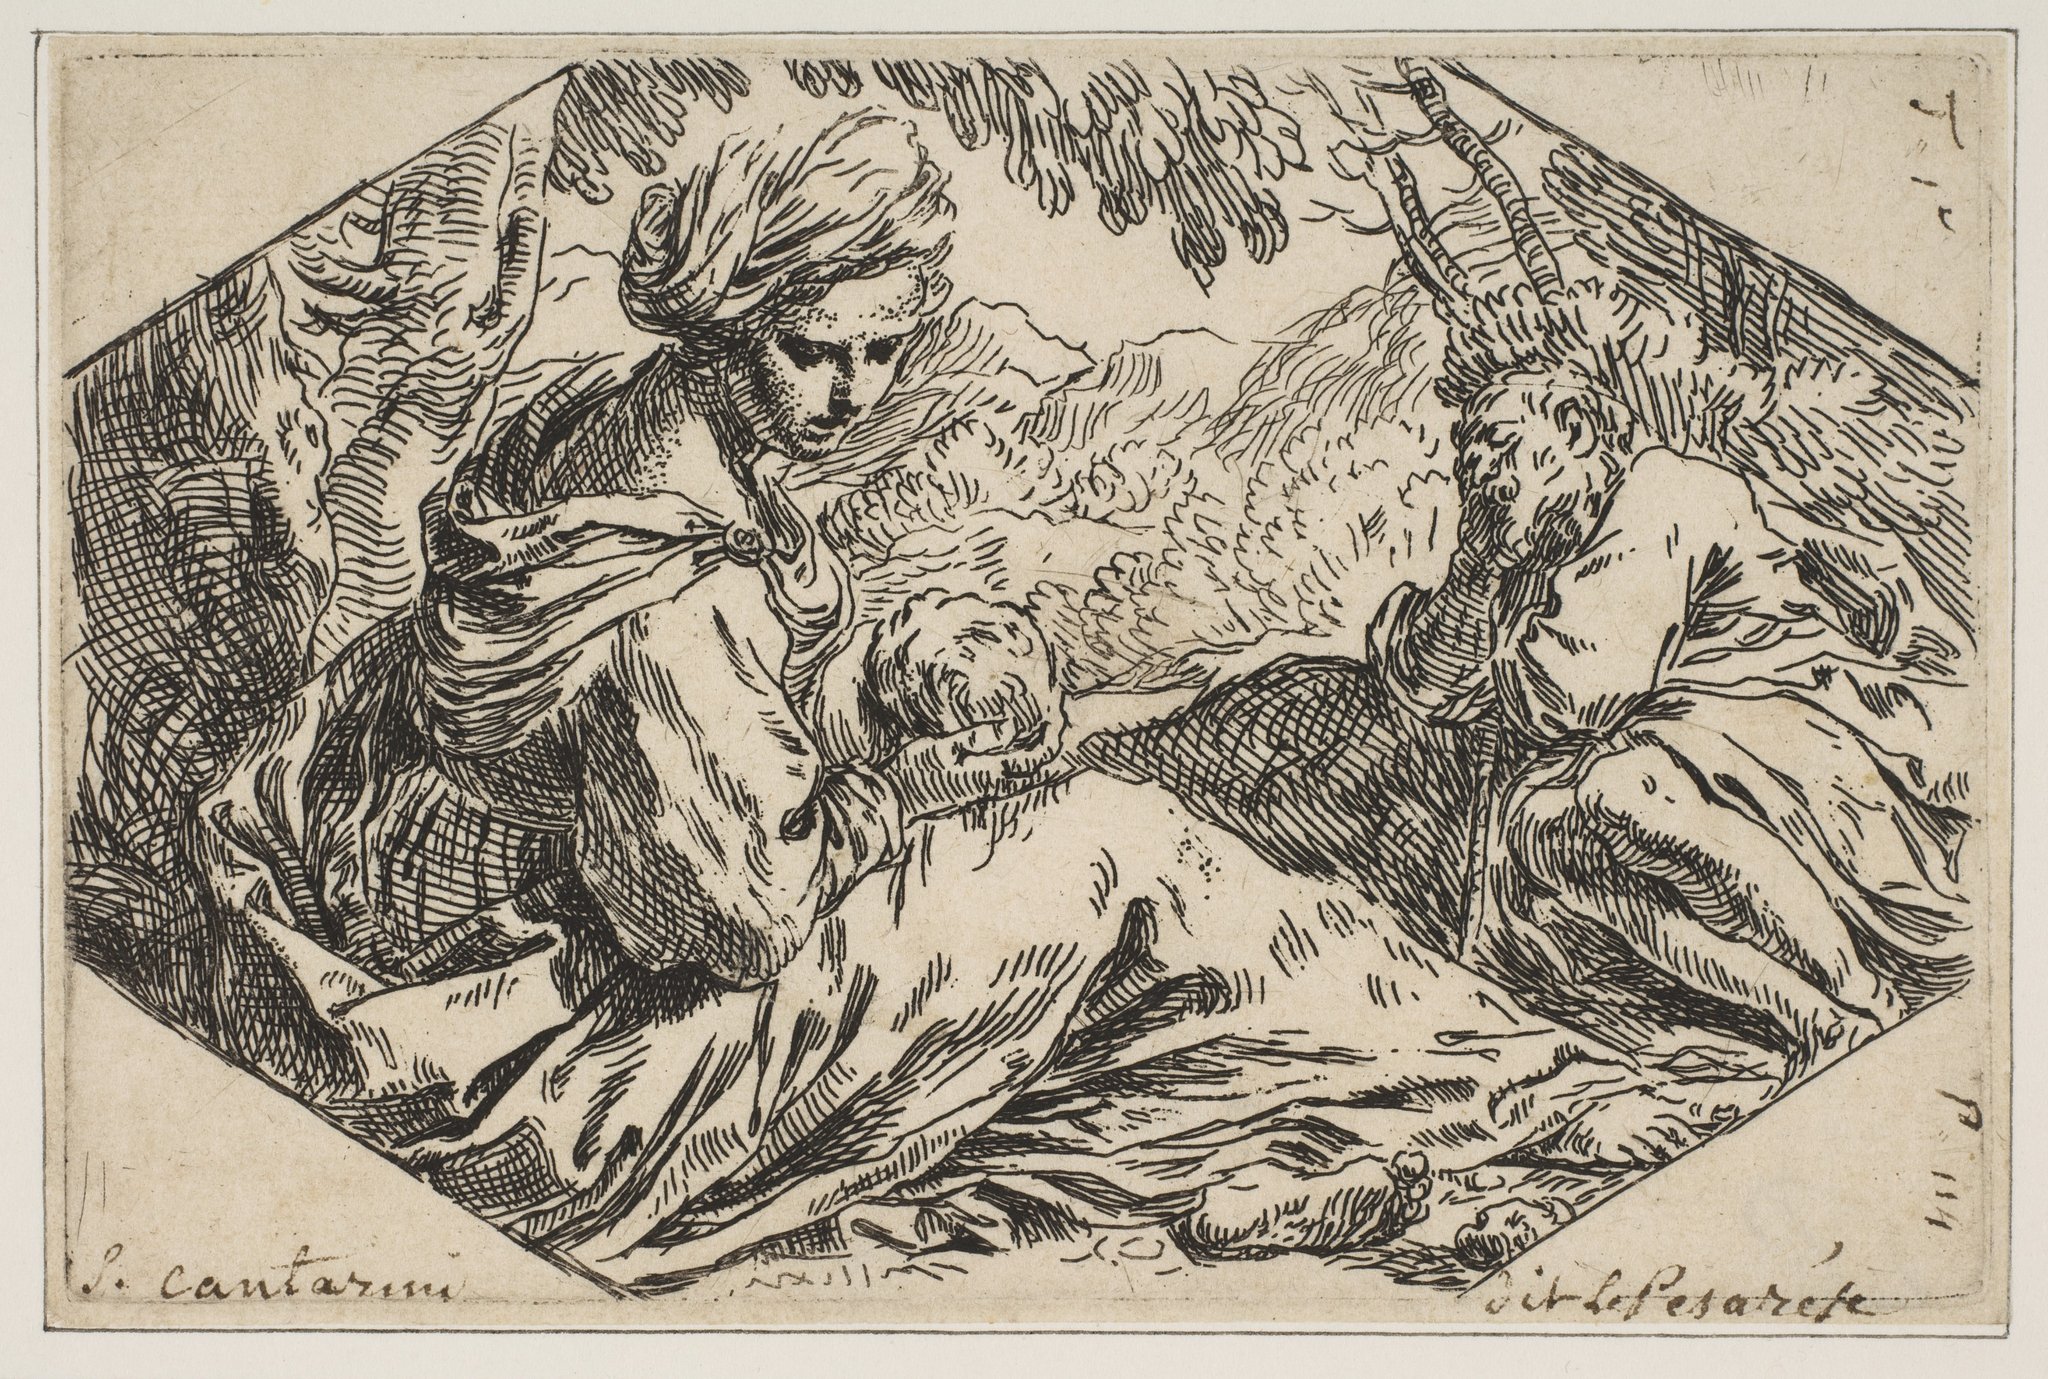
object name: print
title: Repose in Egypt, Mary holding and looking at the infant Christ while St. Joseph sleeps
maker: simone cantarini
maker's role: artist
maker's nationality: italian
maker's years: 1612-1648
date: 1637-1639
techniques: etching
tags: sleeping,men,virgin mary,jesus